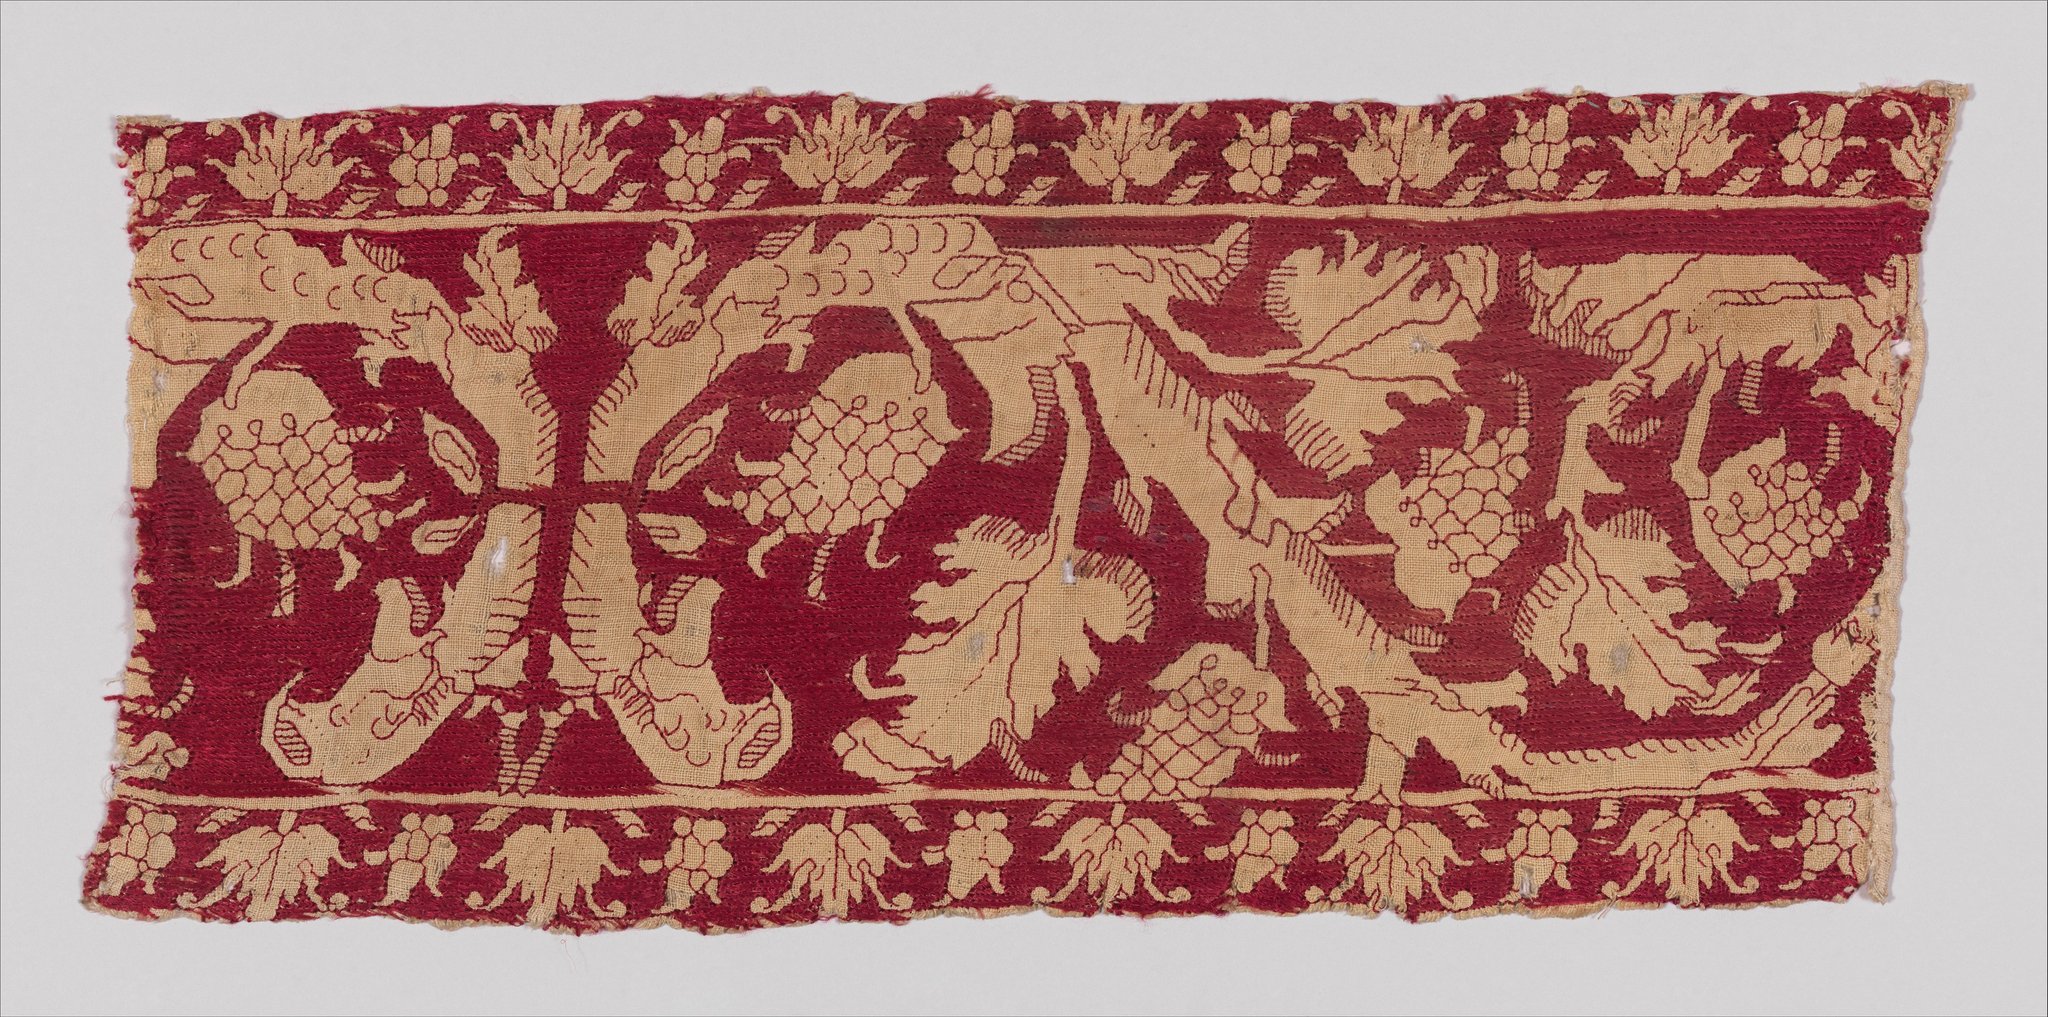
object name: band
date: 1601-1700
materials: linen, silk